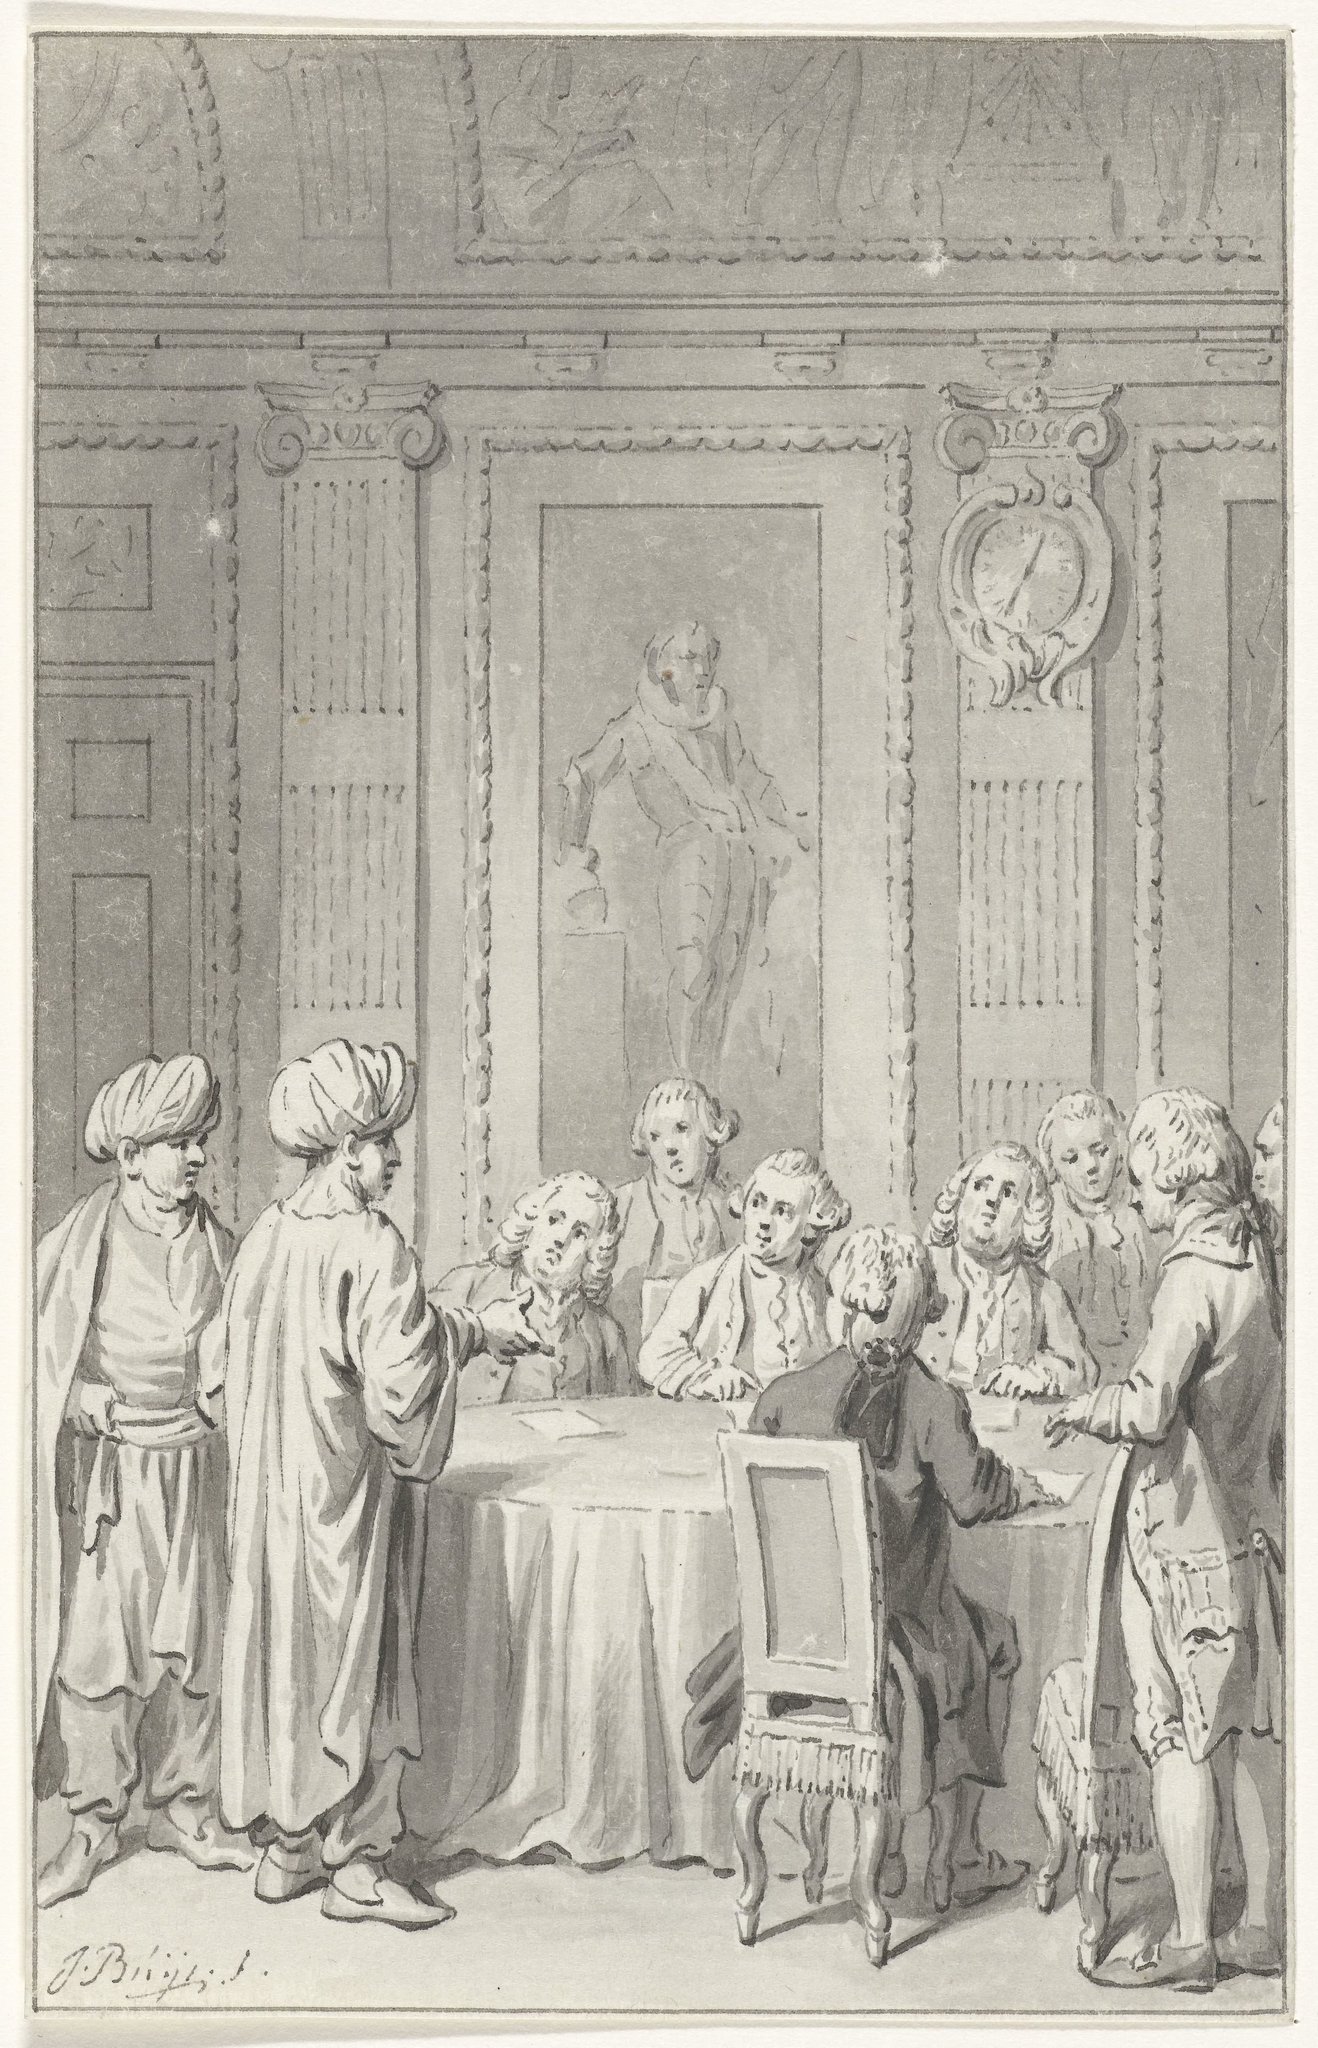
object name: drawing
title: Ontvangst van de Marrokaanse gezant door de Staten Generaal, 6 september 1770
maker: jacobus buys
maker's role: draughtsman, print maker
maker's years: 1724-1801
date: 1770-1801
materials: ink, paper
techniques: brush, pen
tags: names of organizations, companies, trade unions, etc., reception ~ ambassador, historical events and situations, the hague